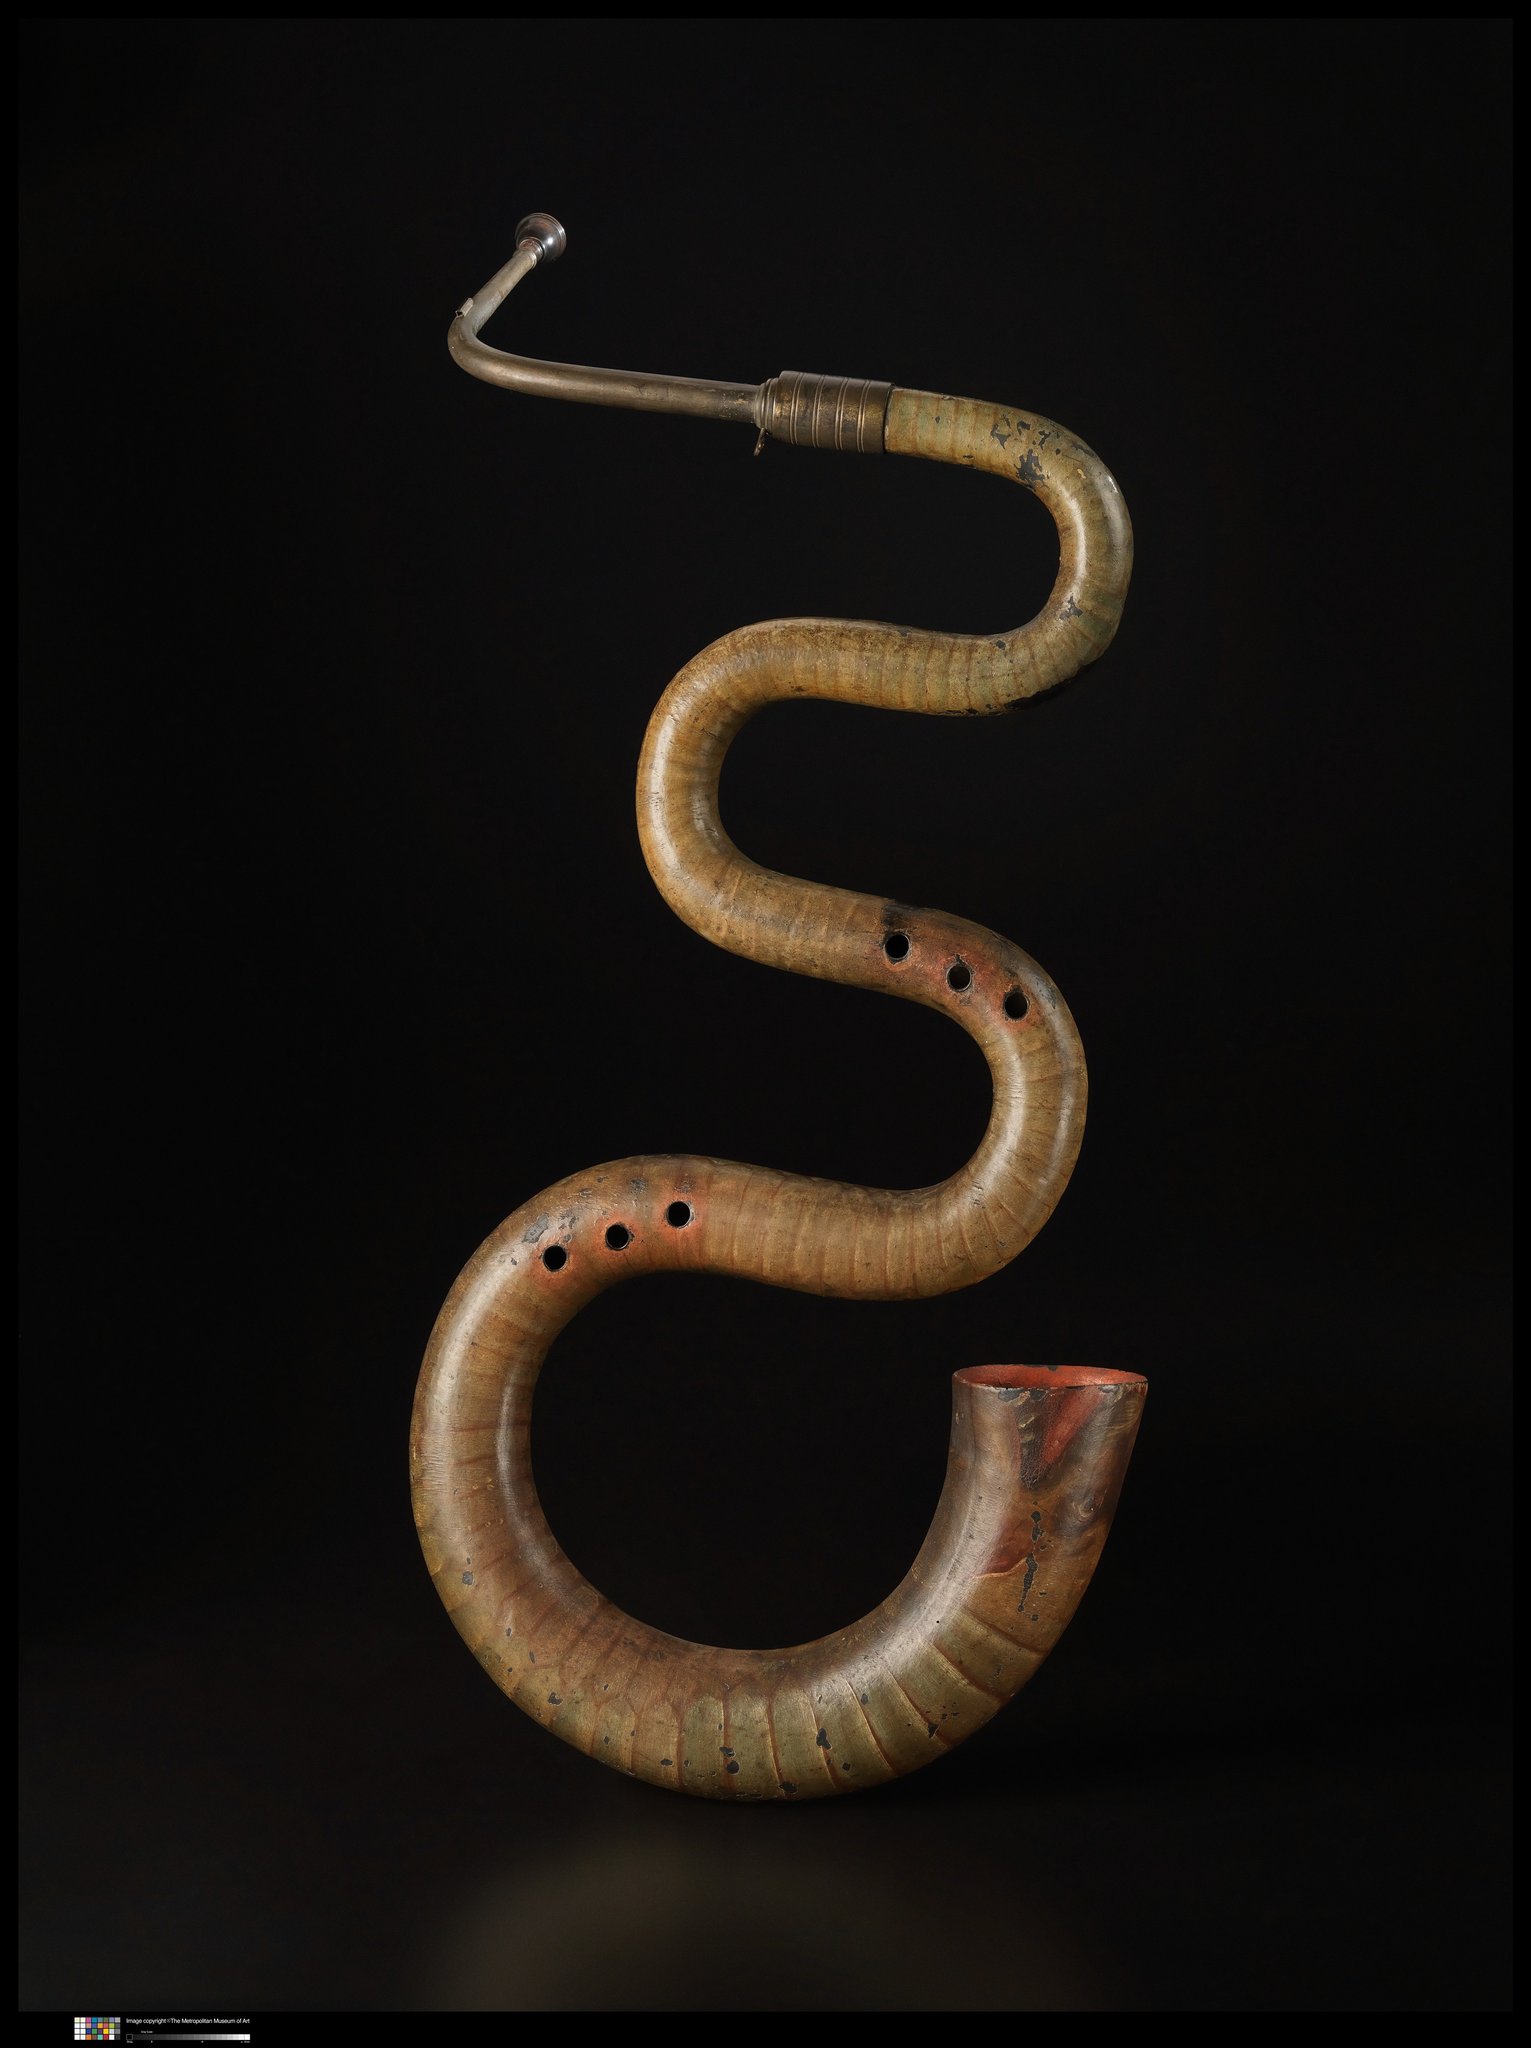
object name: serpent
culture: french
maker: c. baudouin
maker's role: maker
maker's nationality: french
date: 1820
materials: brass, leather, paint, wood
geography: france